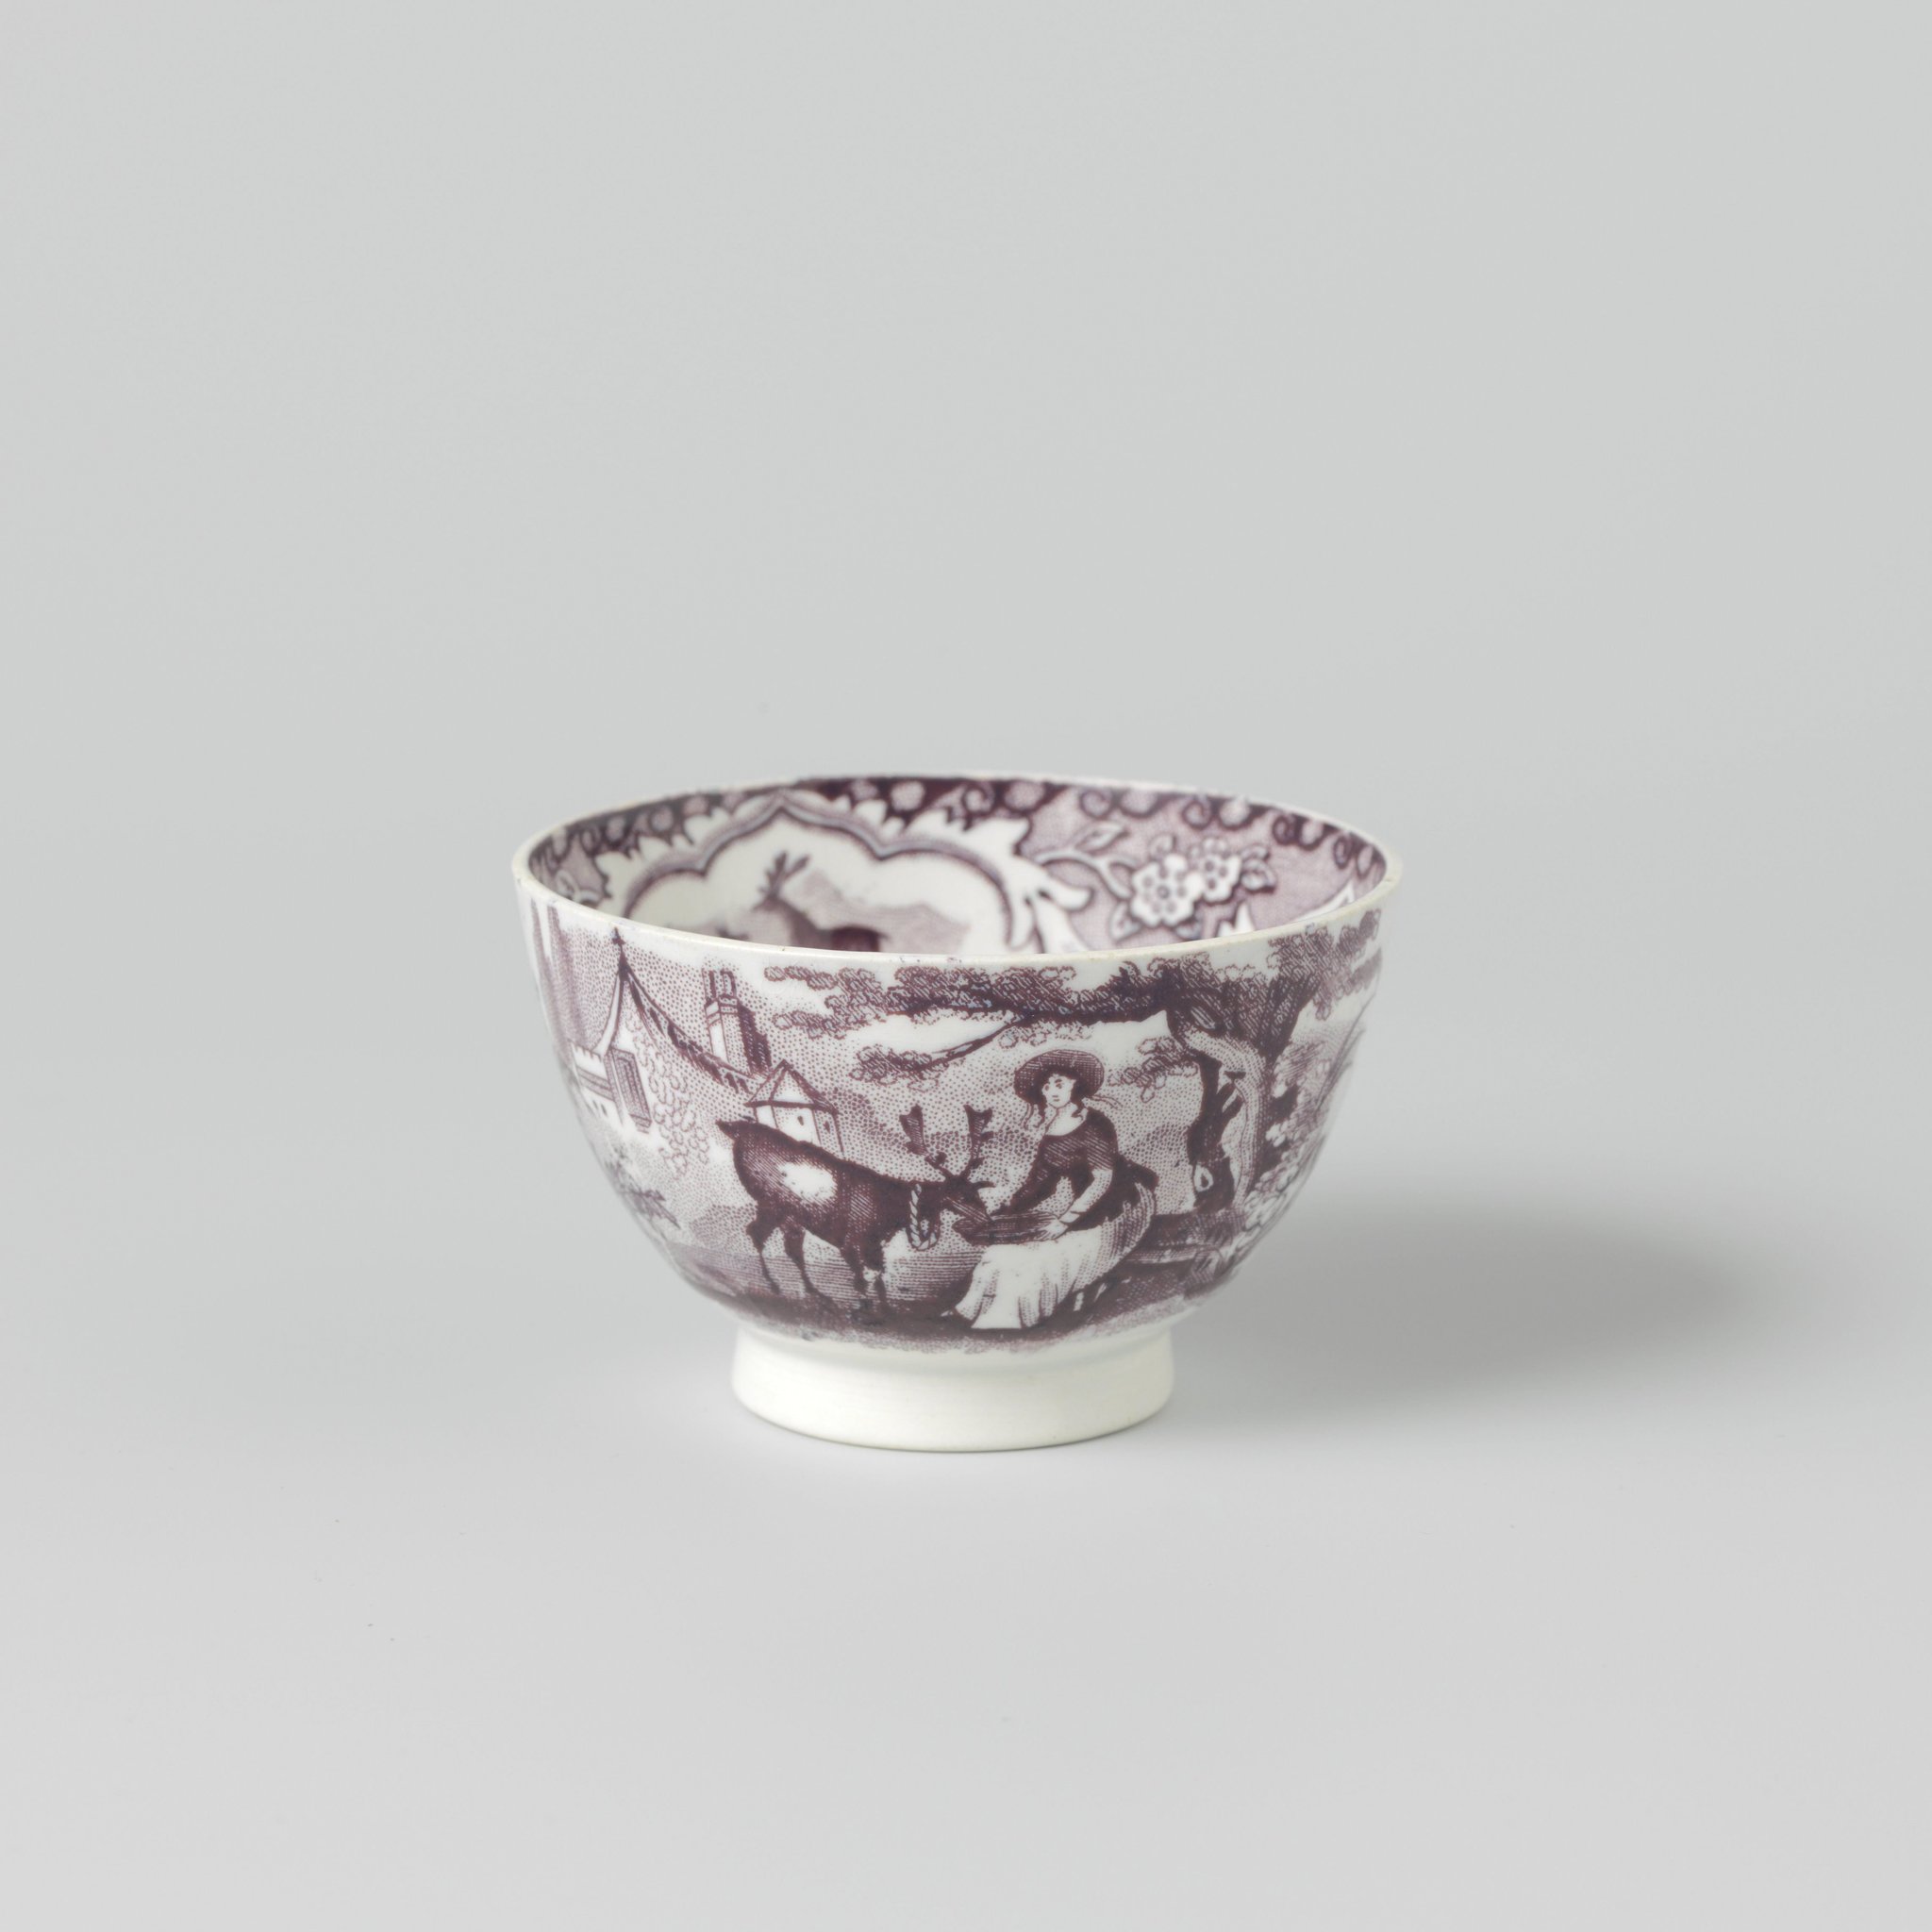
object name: cup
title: Kop met een vrouw die een hert voert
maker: petrus regout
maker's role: plateelbakker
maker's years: 1801-1879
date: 1801-1879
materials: earthenware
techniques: transfer decoration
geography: maastricht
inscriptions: mark: ‘1 // 50’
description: Kop van aardewerk met een paars transferdecor. Op de buitenzijde van de wand een voorstelling van een vrouw die een hert voert. Aan de binnenzijde van de wand twee cartouches met herten. Op de bodem van de kom een voorstelling van twee herten.